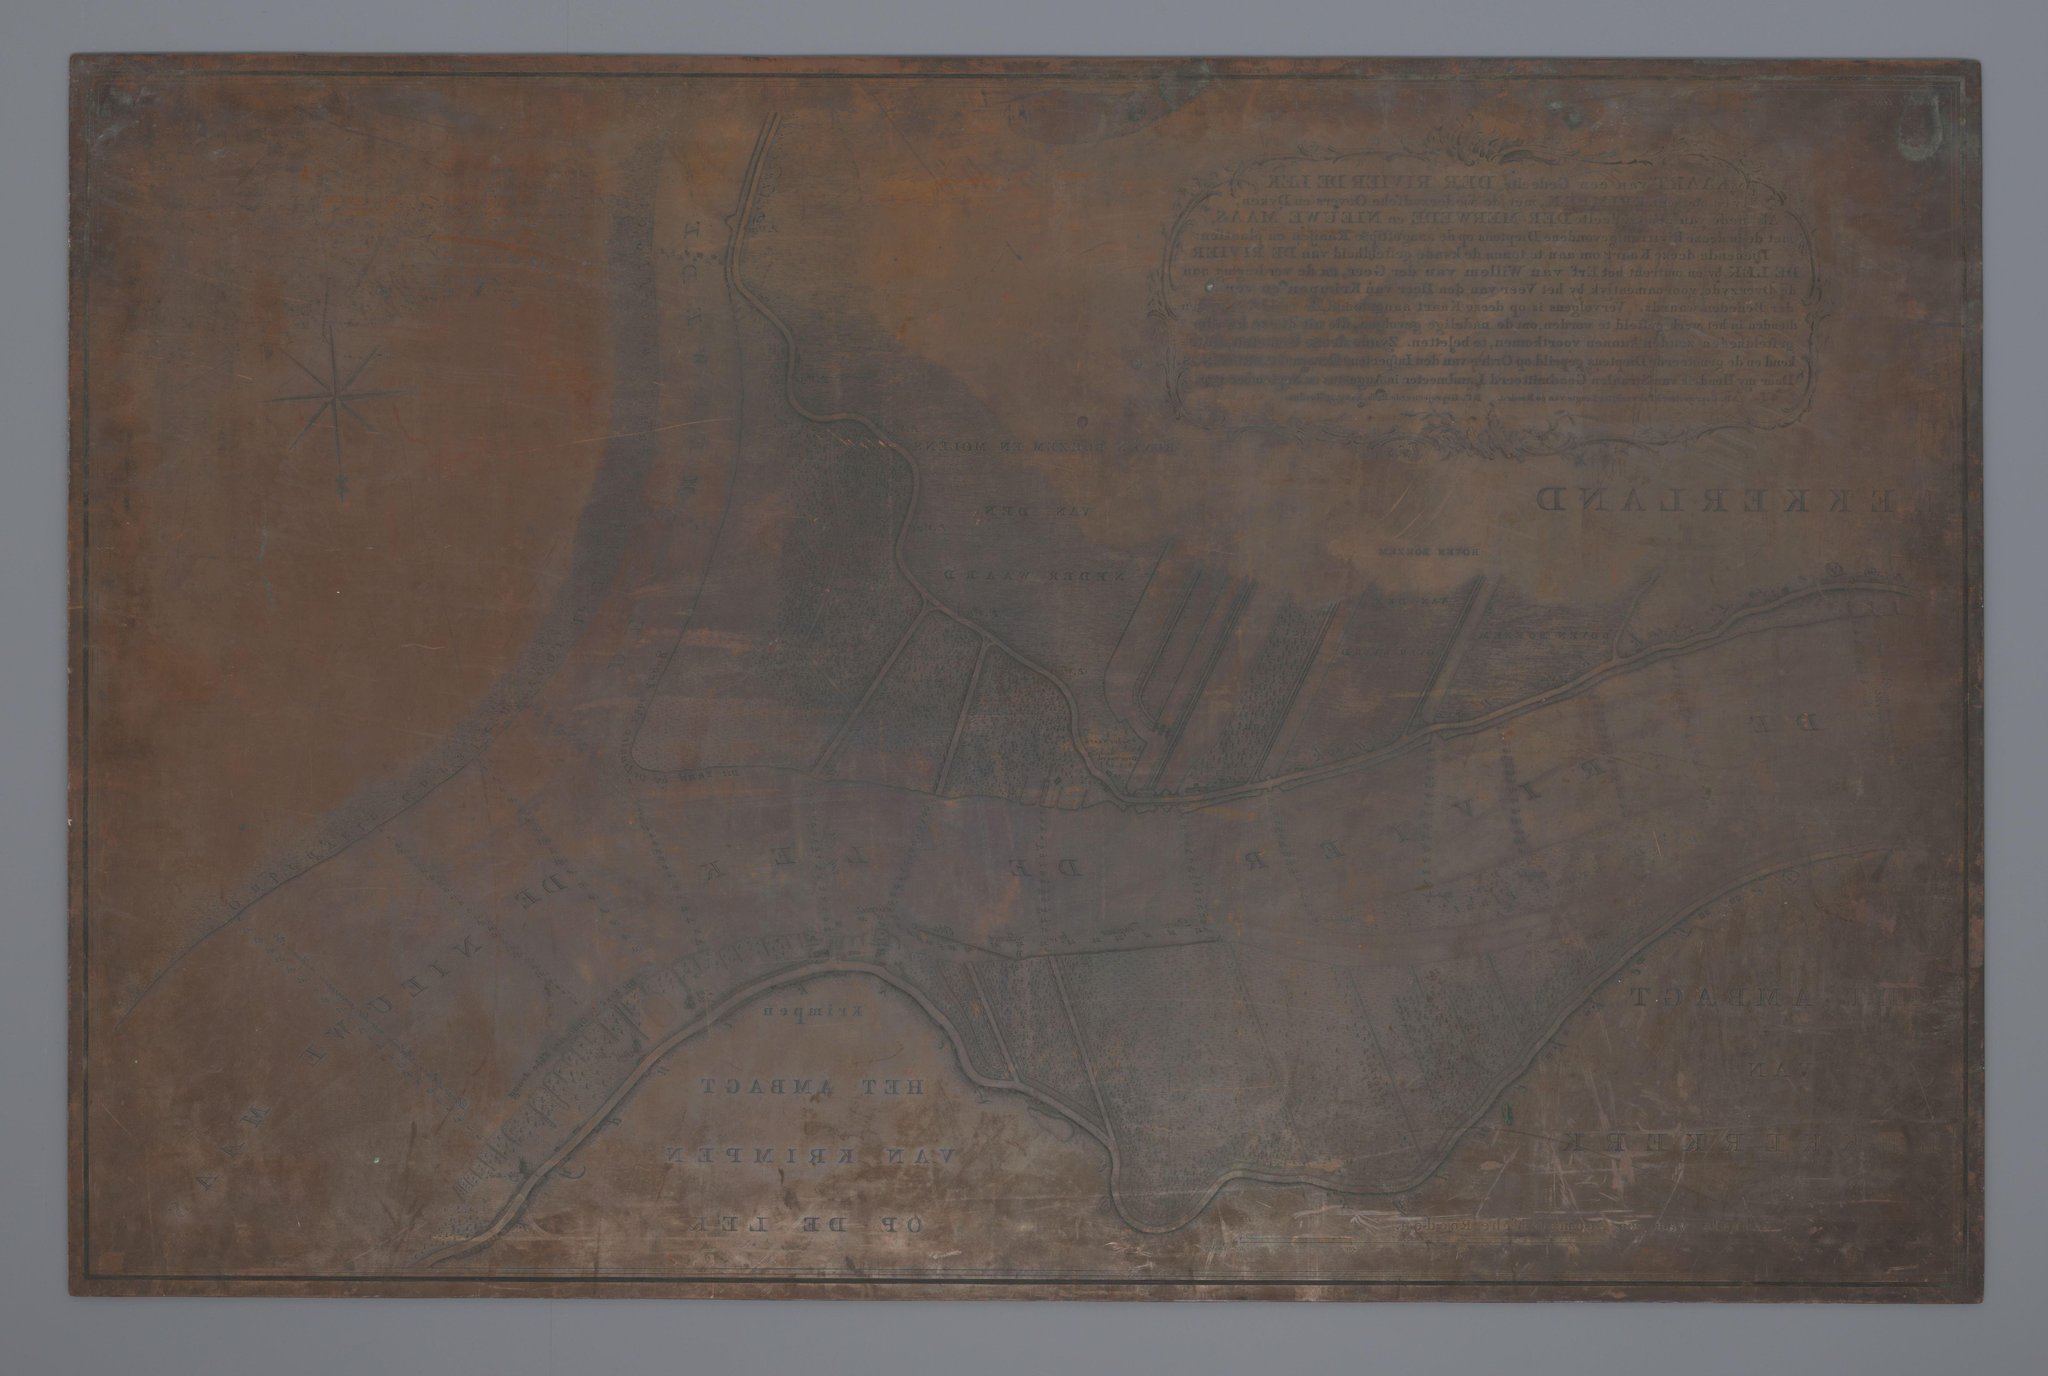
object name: copper plate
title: Kaart van een gedeelte der rivier de Lek by en omtrent Krimpen (...)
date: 1781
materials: copper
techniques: engraving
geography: the hague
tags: krimpen aan de lek, lek